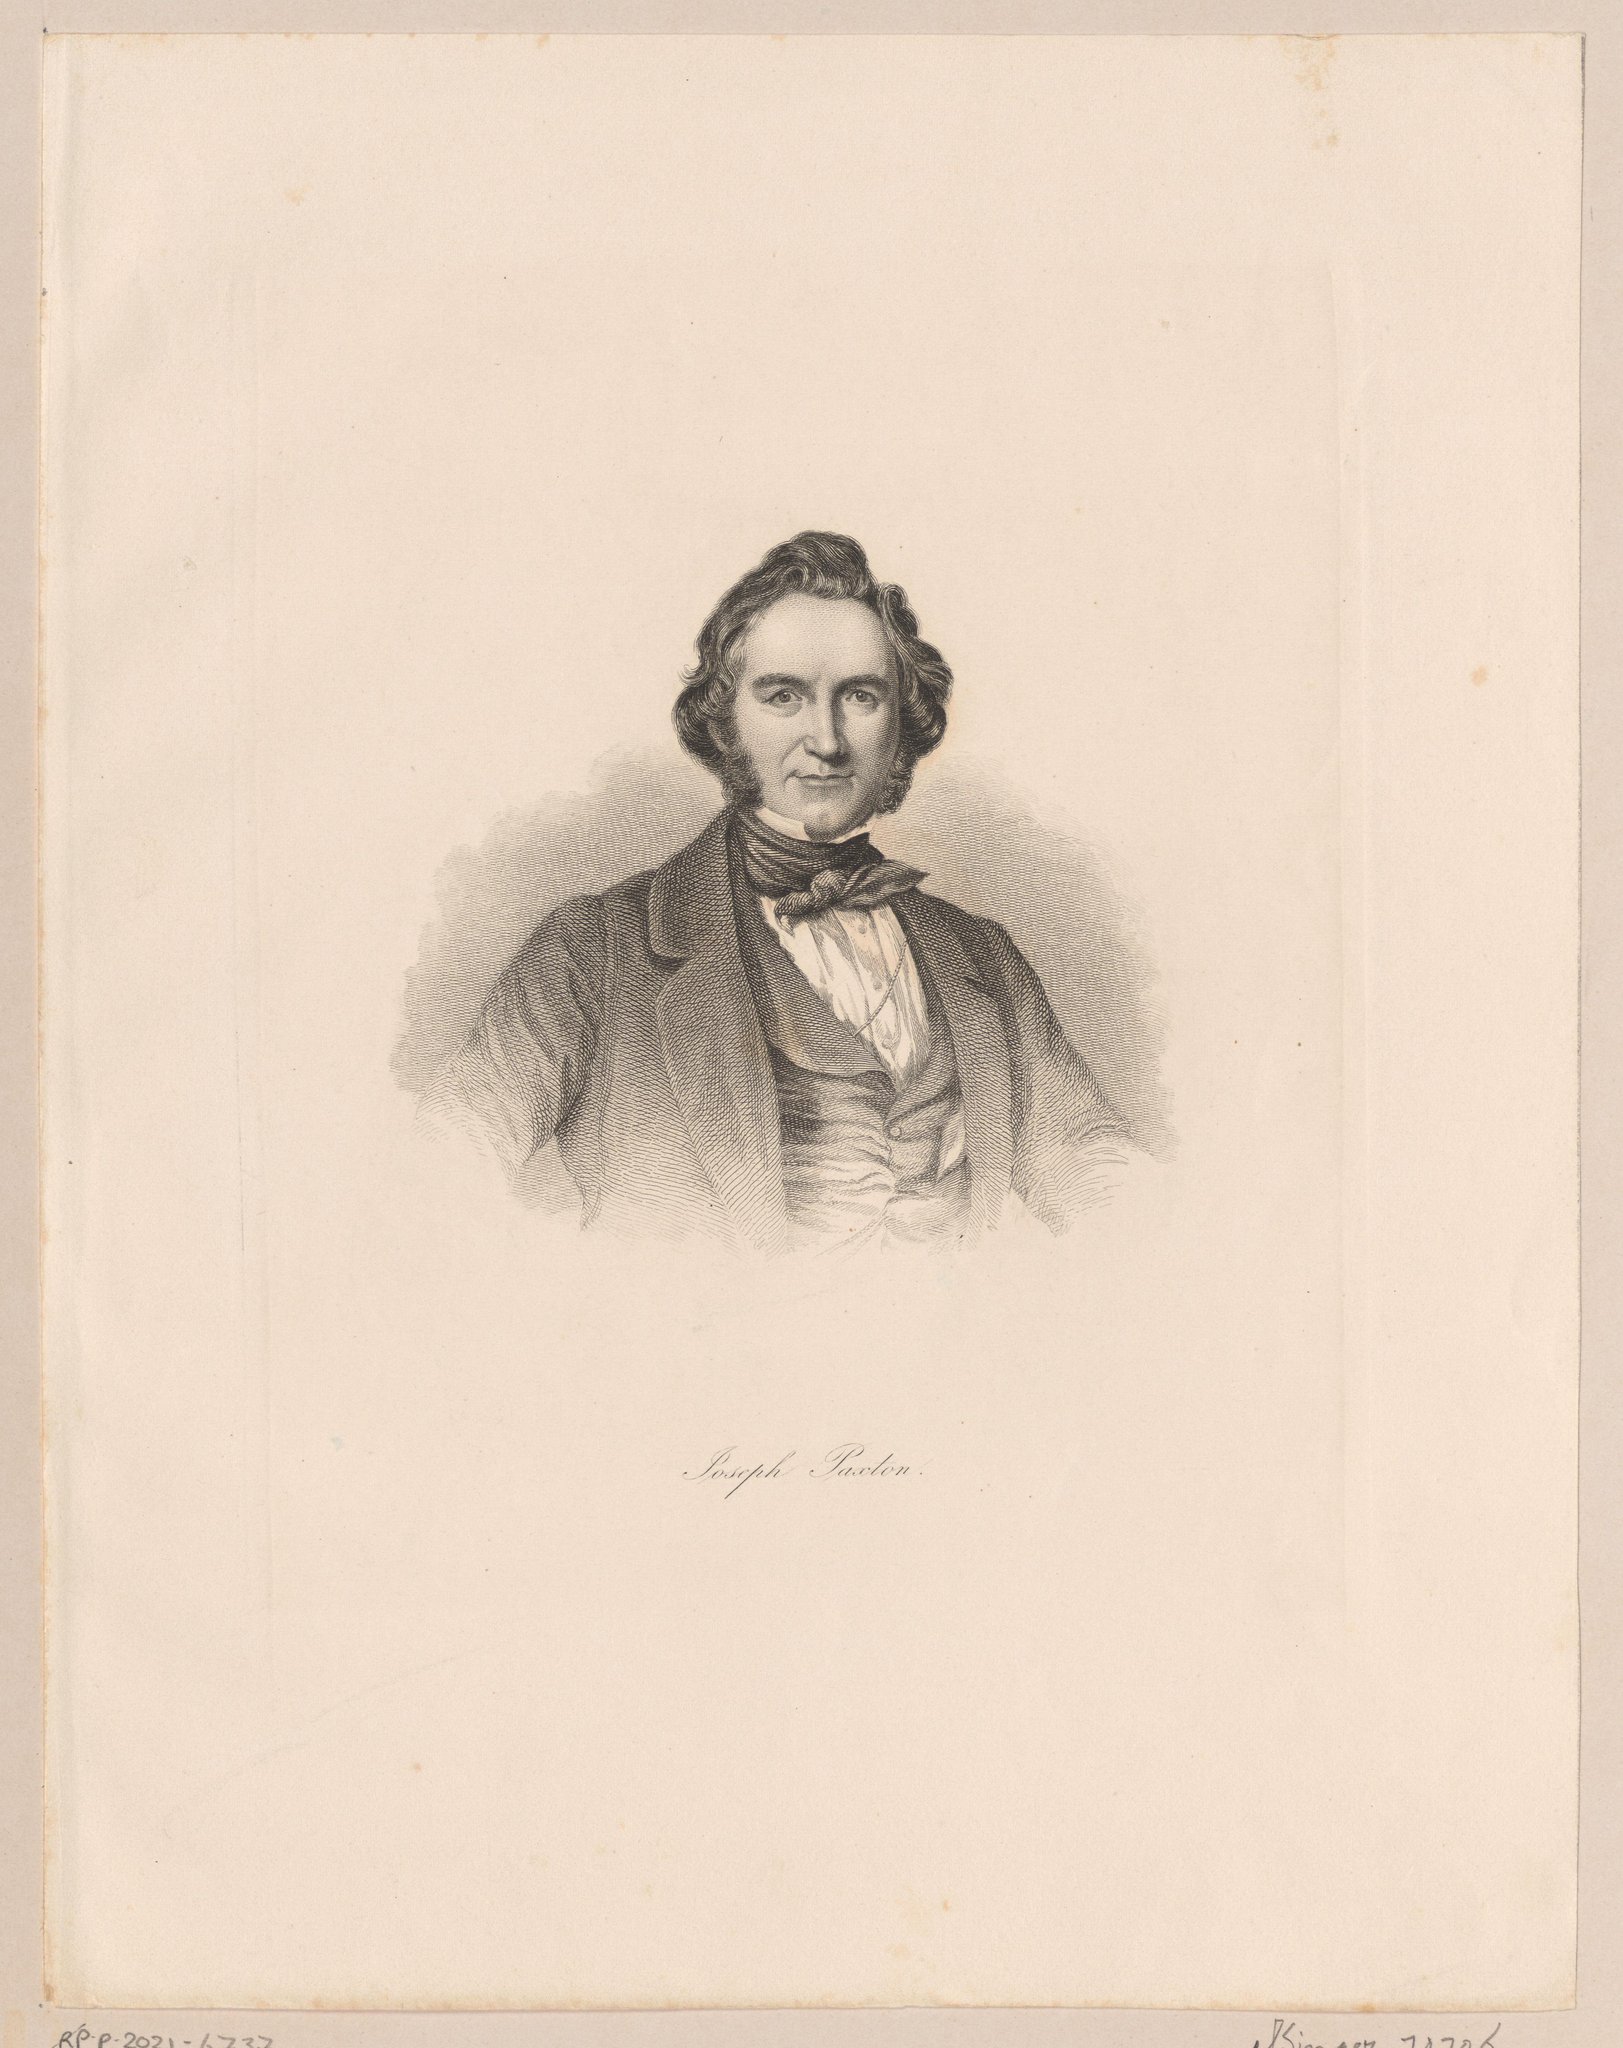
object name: print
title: Portret van Joseph Paxton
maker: Anonymous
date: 1821-1899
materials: paper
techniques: engraving, etching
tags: joseph paxton, adult man, historical persons